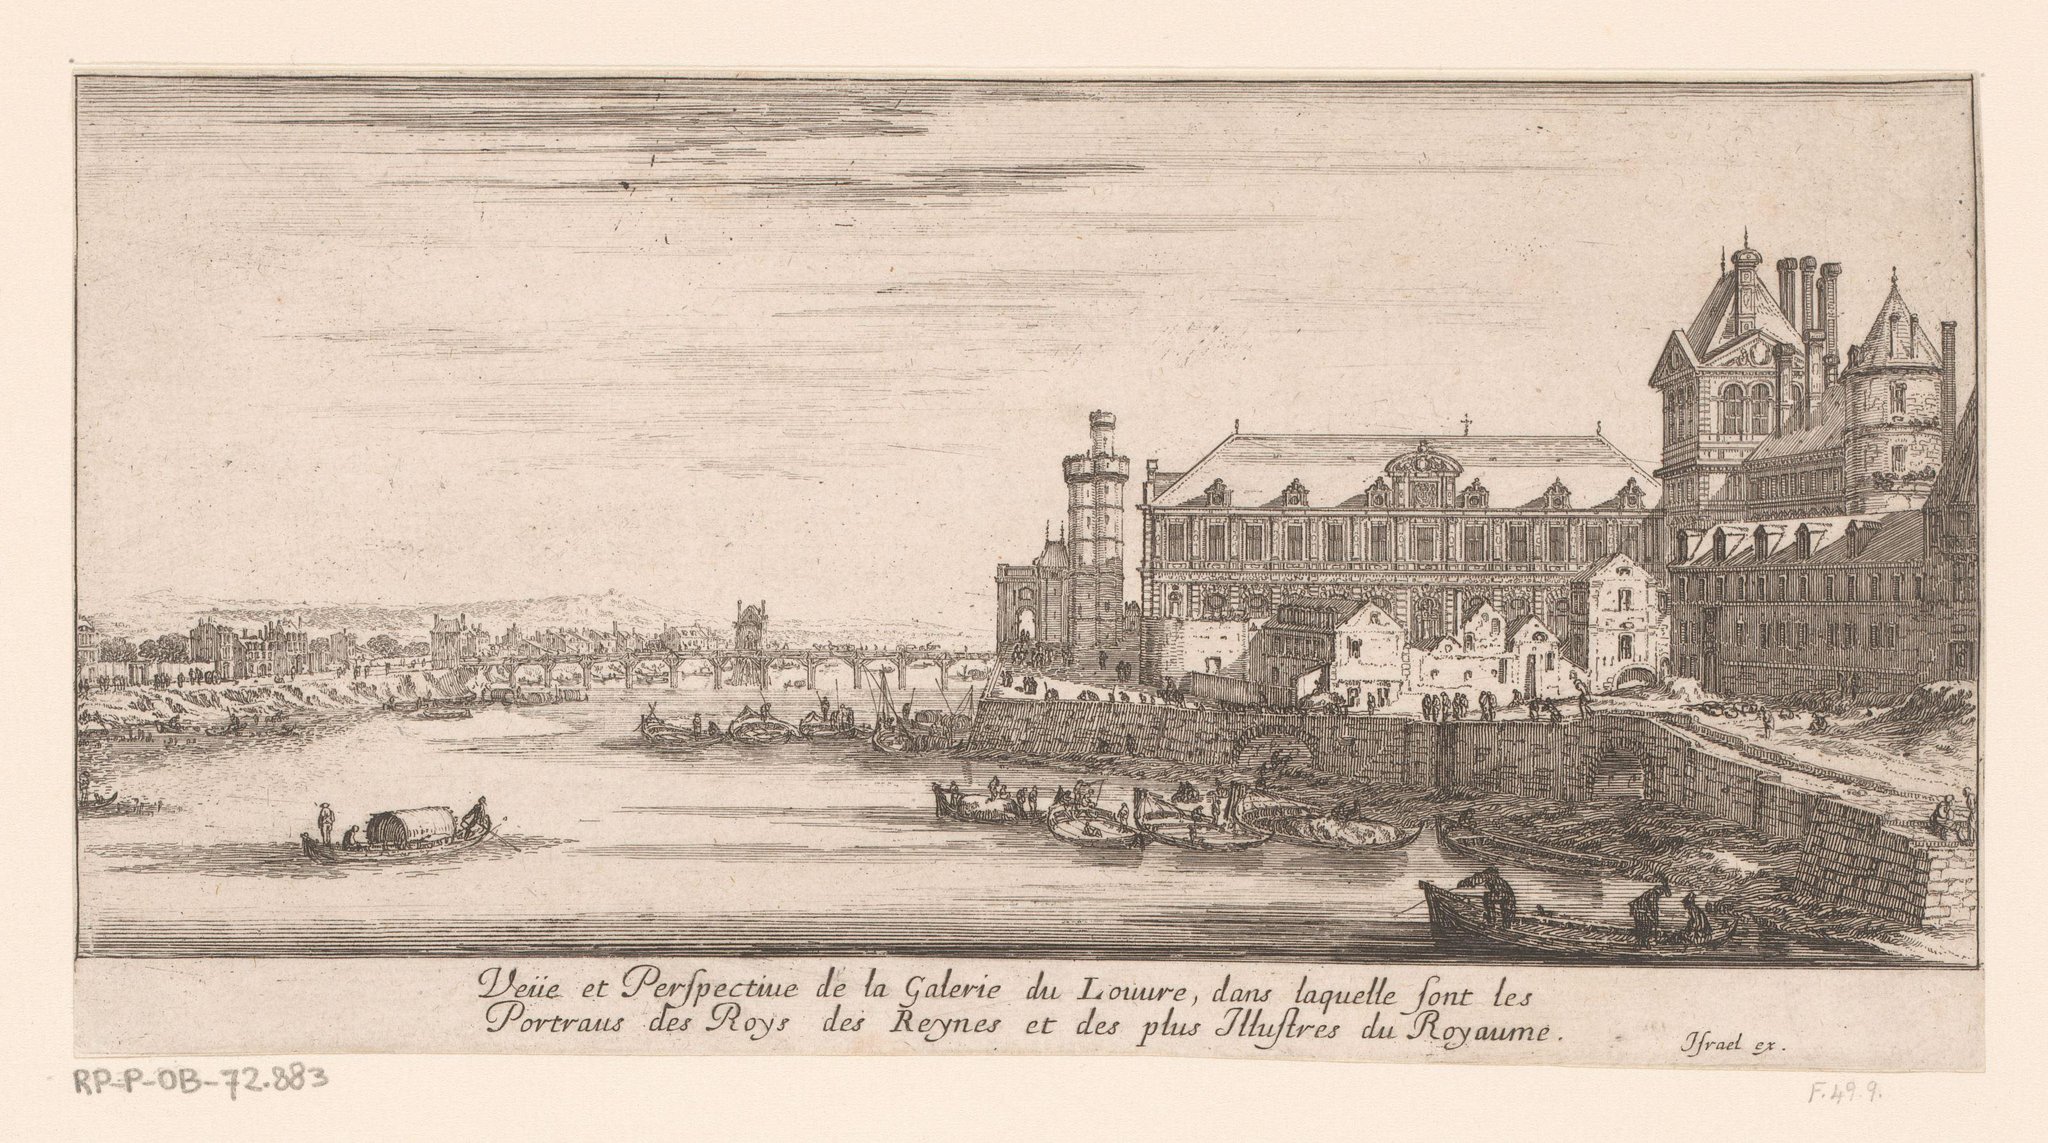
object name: print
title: Gezicht op het Louvre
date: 1650-1655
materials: paper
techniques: engraving, etching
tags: city-view, and landscape with man-made constructions (+ city(-scape) with figures, staffage)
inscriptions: collector's mark: Lugt 240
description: Prent maakt deel uit van een ongenummerde serie van dertien prenten.